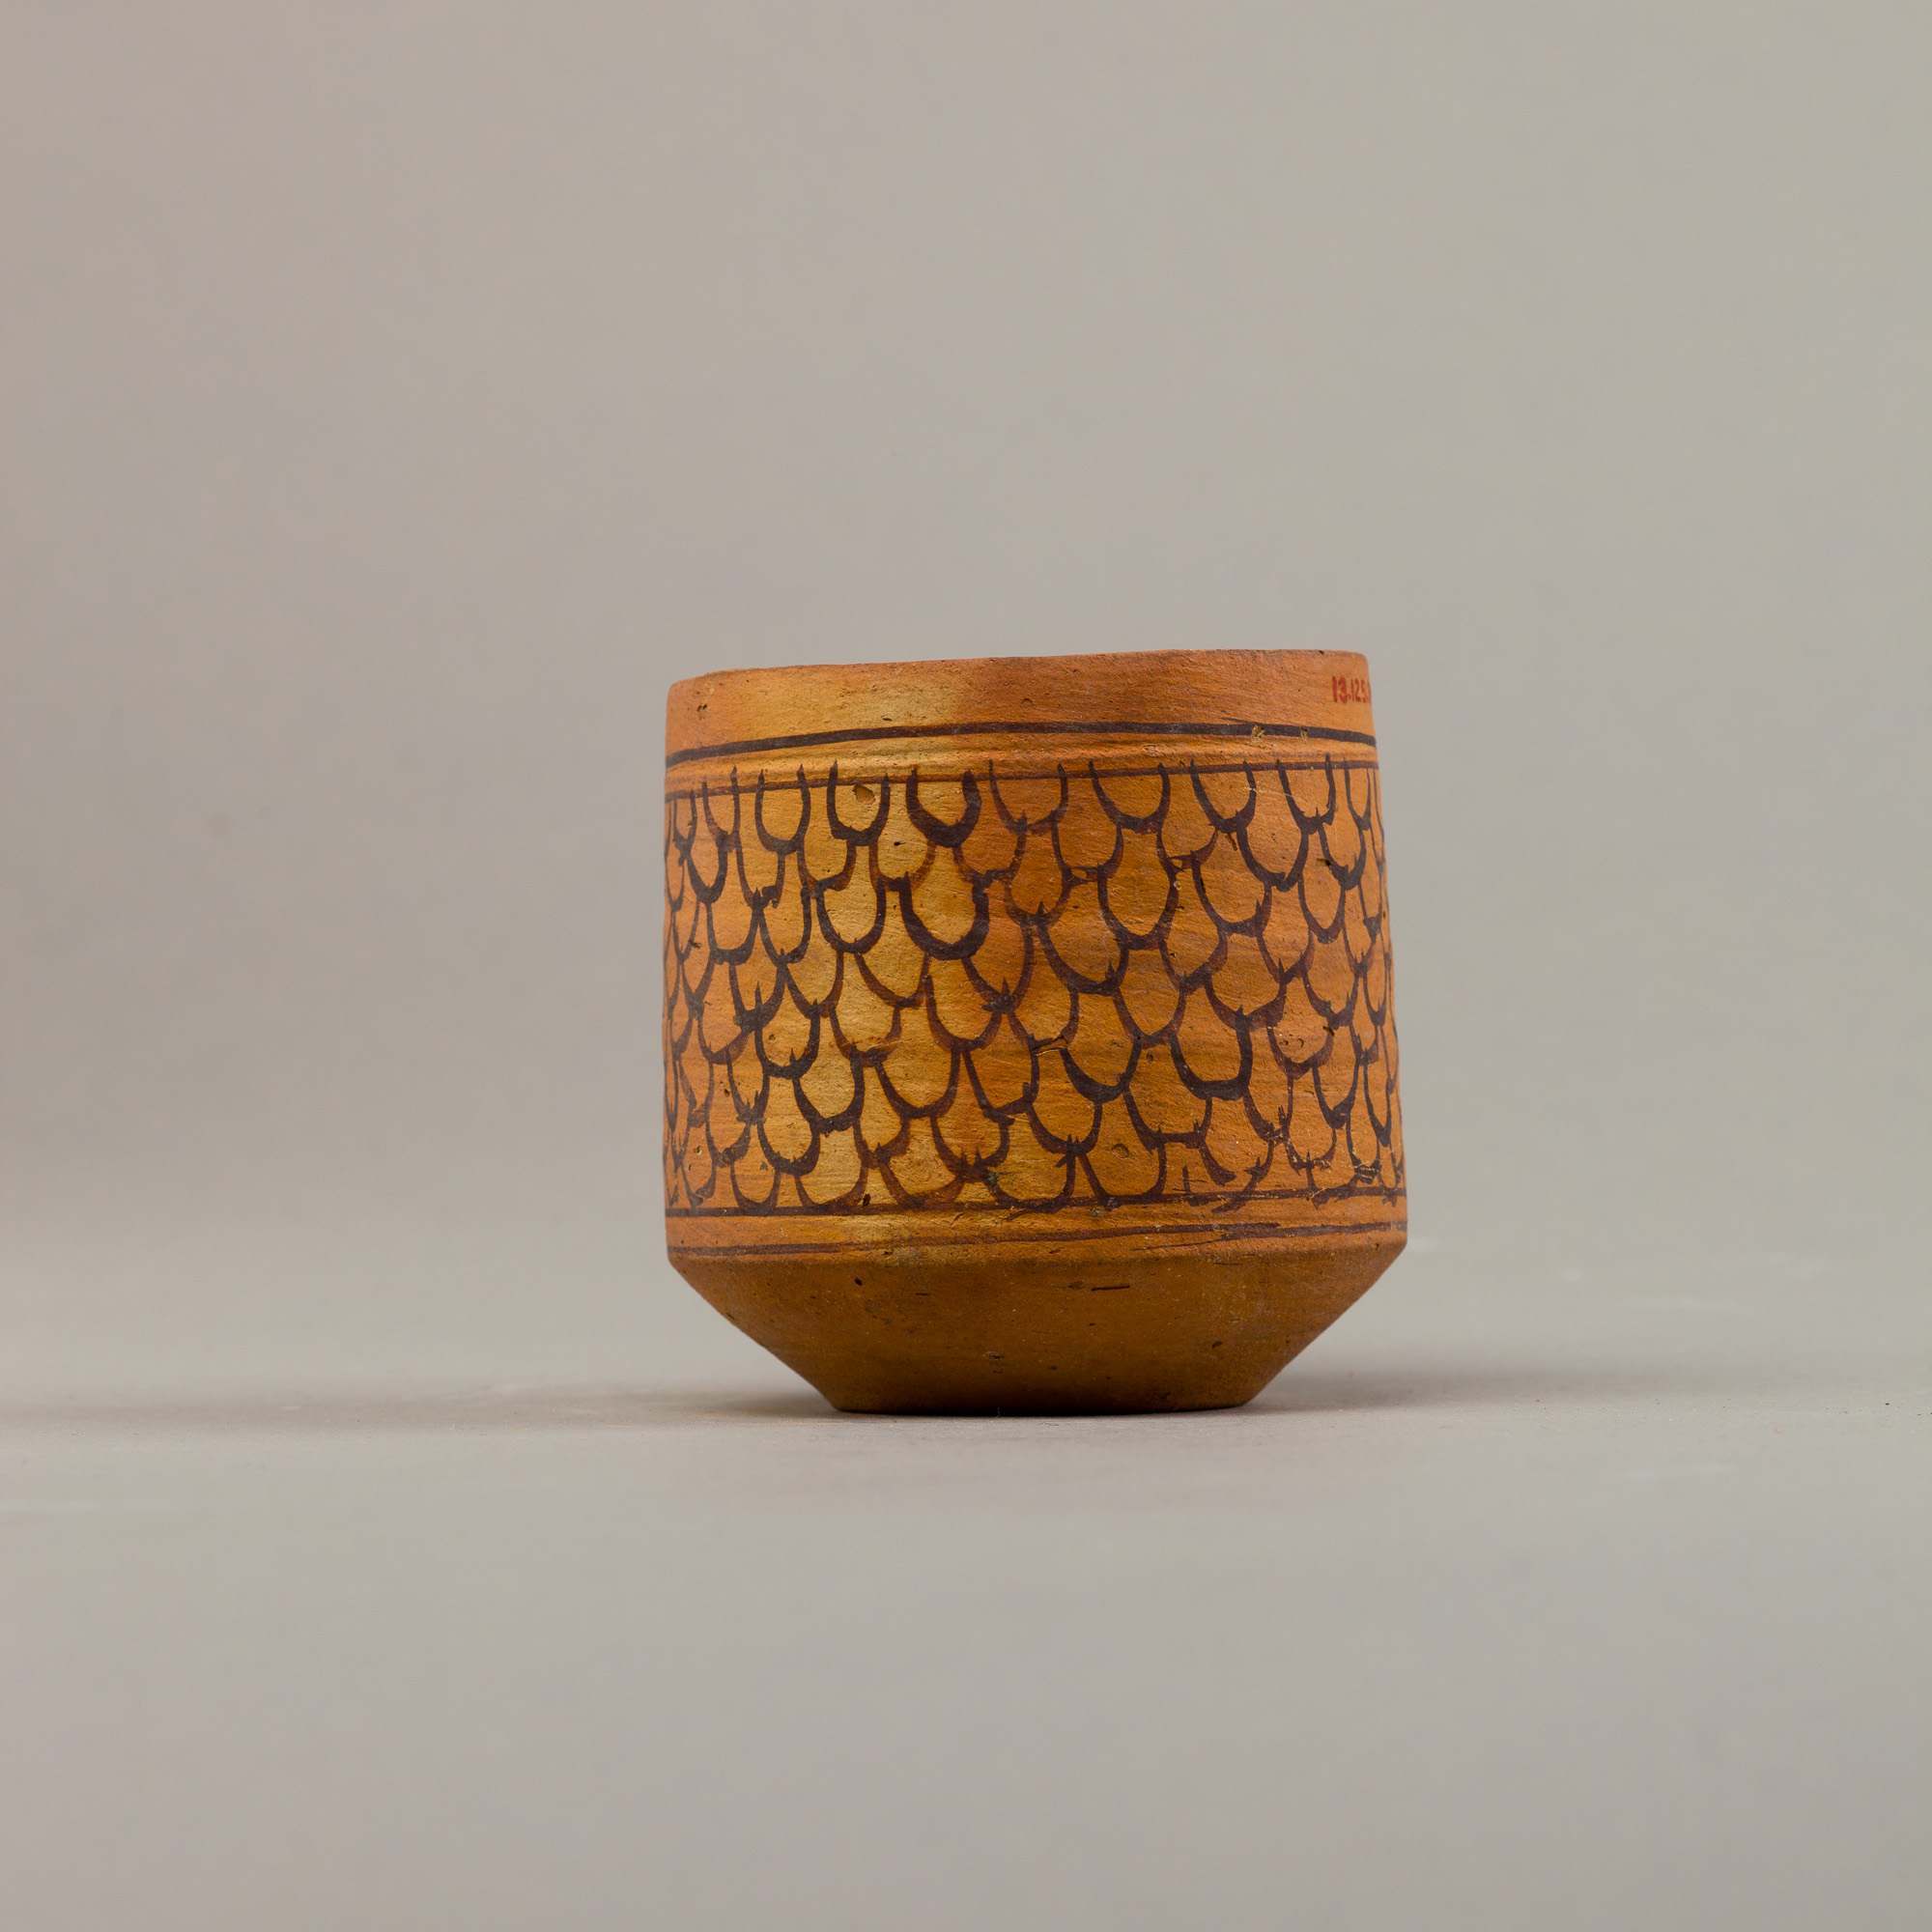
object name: cup, feather pattern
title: Cup with feather (?) decoration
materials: paint, pottery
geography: nubia